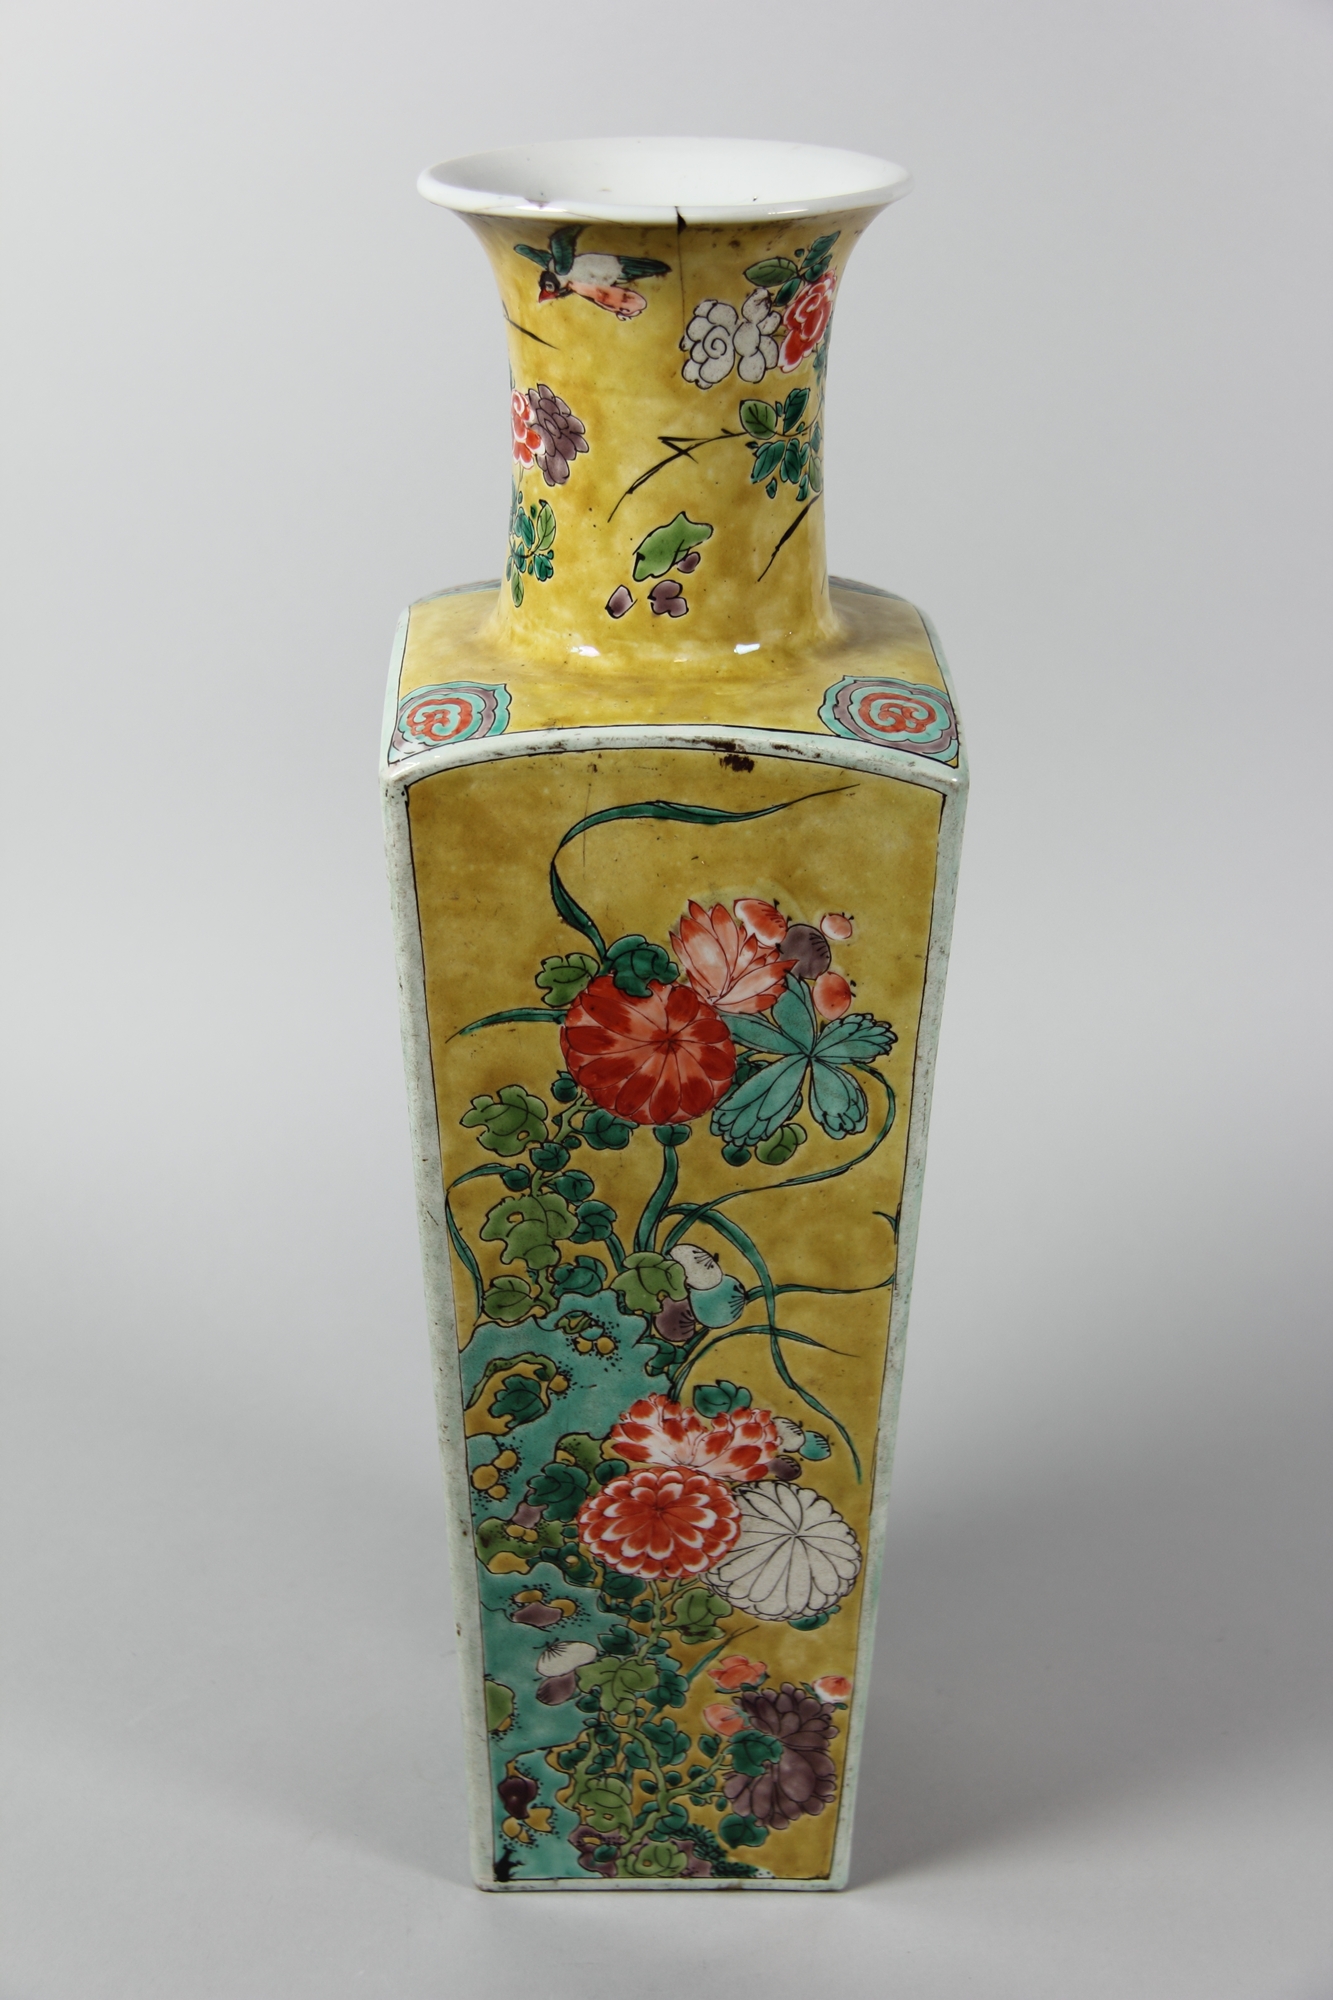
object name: vase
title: Square vase with scenes of four seasons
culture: chinese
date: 1801-1900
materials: enamel, porcelain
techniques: painting, polychrome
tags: flowers